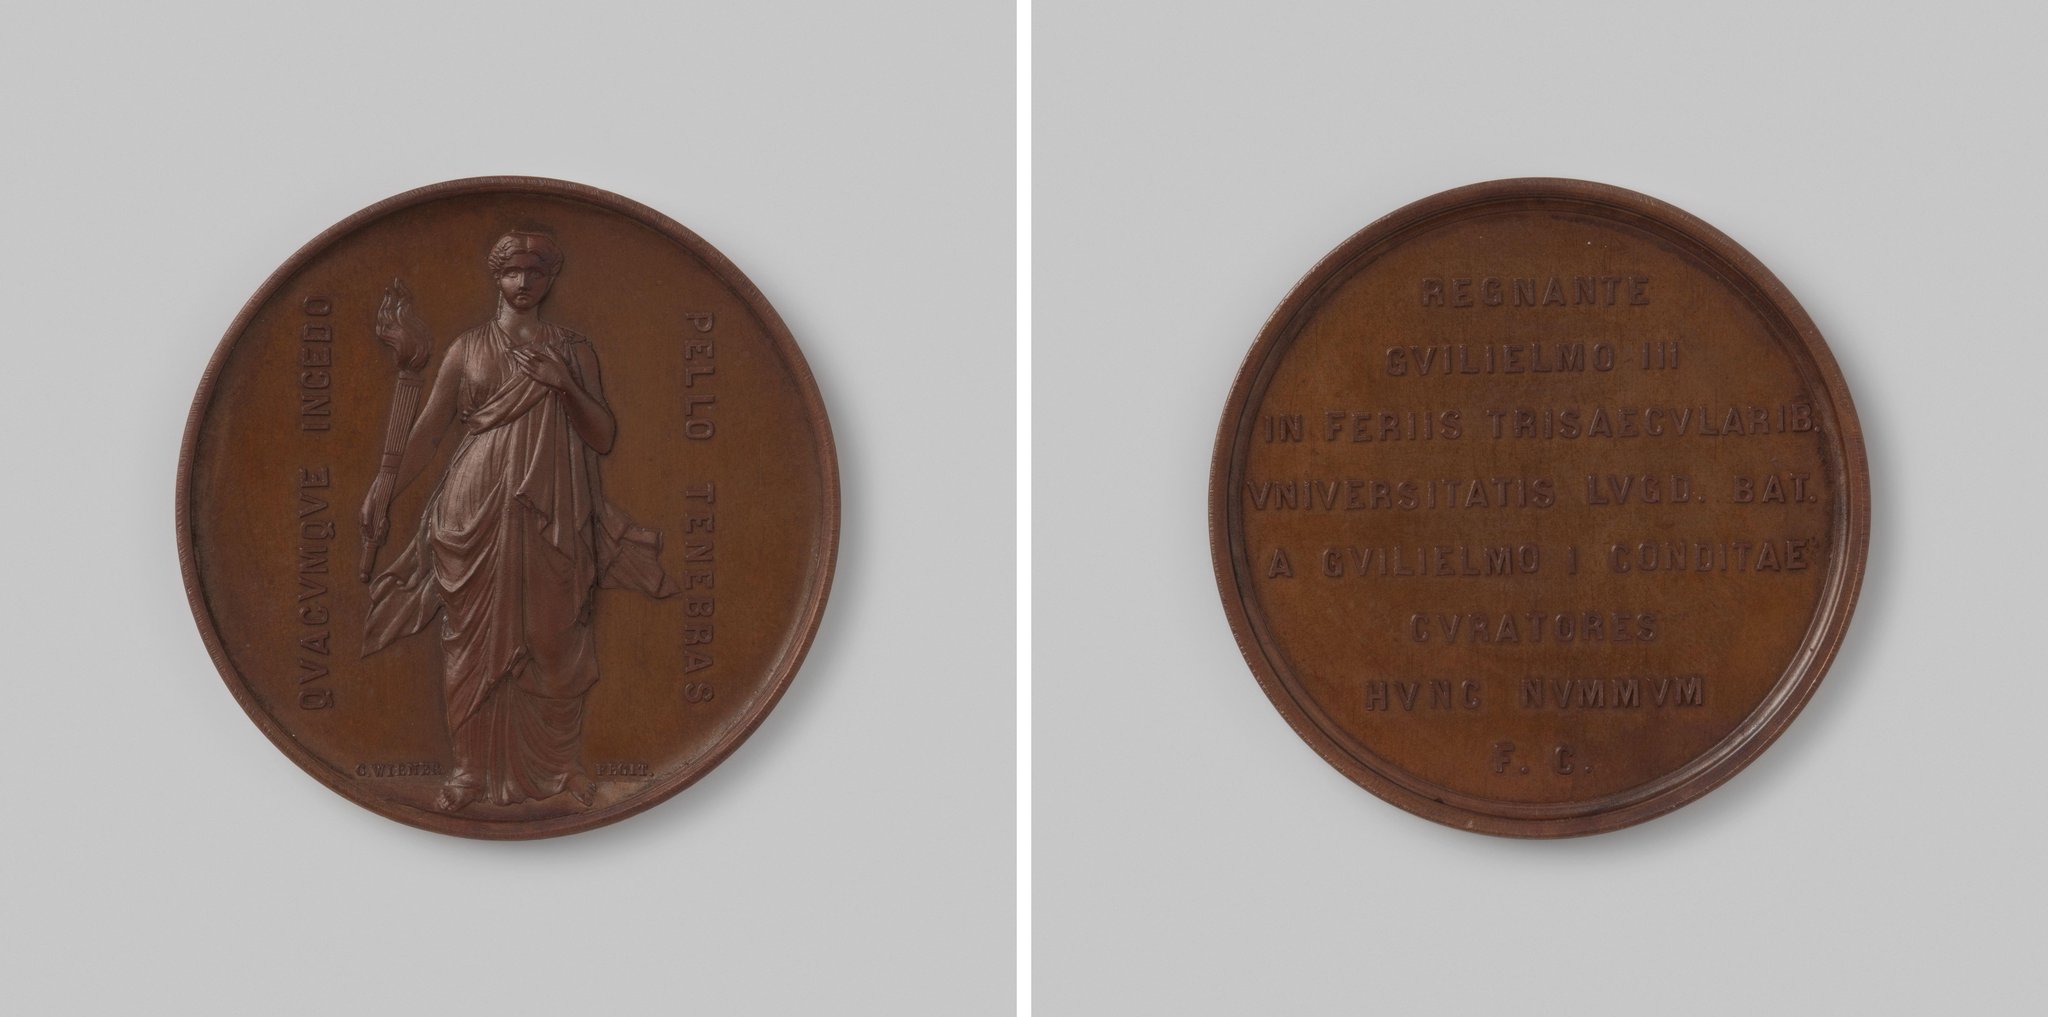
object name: history medal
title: Driehonderdjarig bestaan van de Universiteit van Leiden 1875 (curatorenpenning)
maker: karel wiener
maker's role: medailleur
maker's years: 1831-1888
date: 1875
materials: bronze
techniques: striking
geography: brussels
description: Bronzen penning, op de voorzijde de Wijsheid als staande vrouw met fakkel, met links en rechts rechtopstaande tekst, op de keerzijde acht regels tekst.